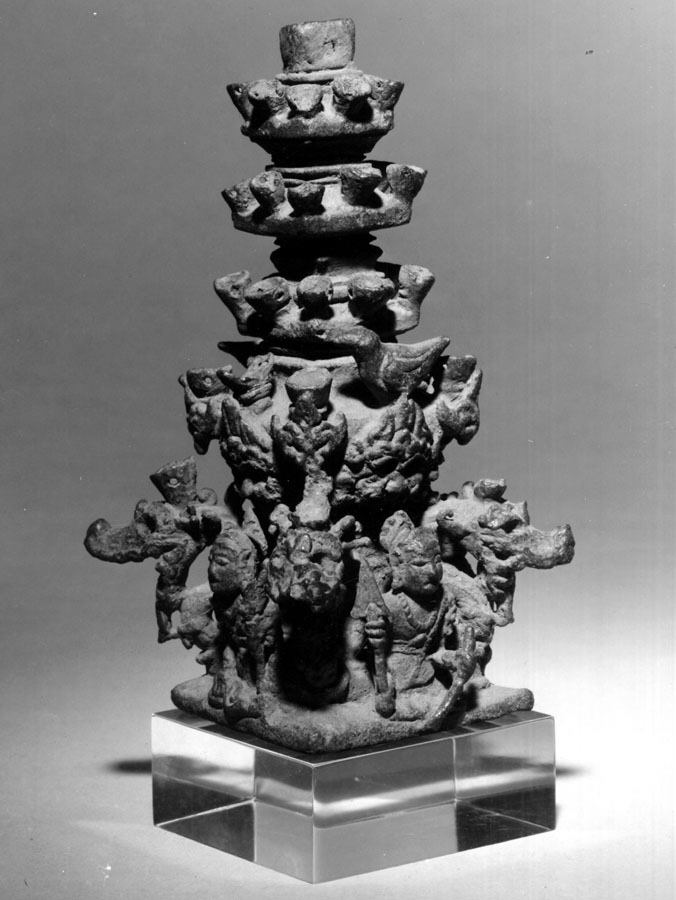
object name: incense holder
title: Incense Stick Holder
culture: indonesian, javanese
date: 901-1100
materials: bronze